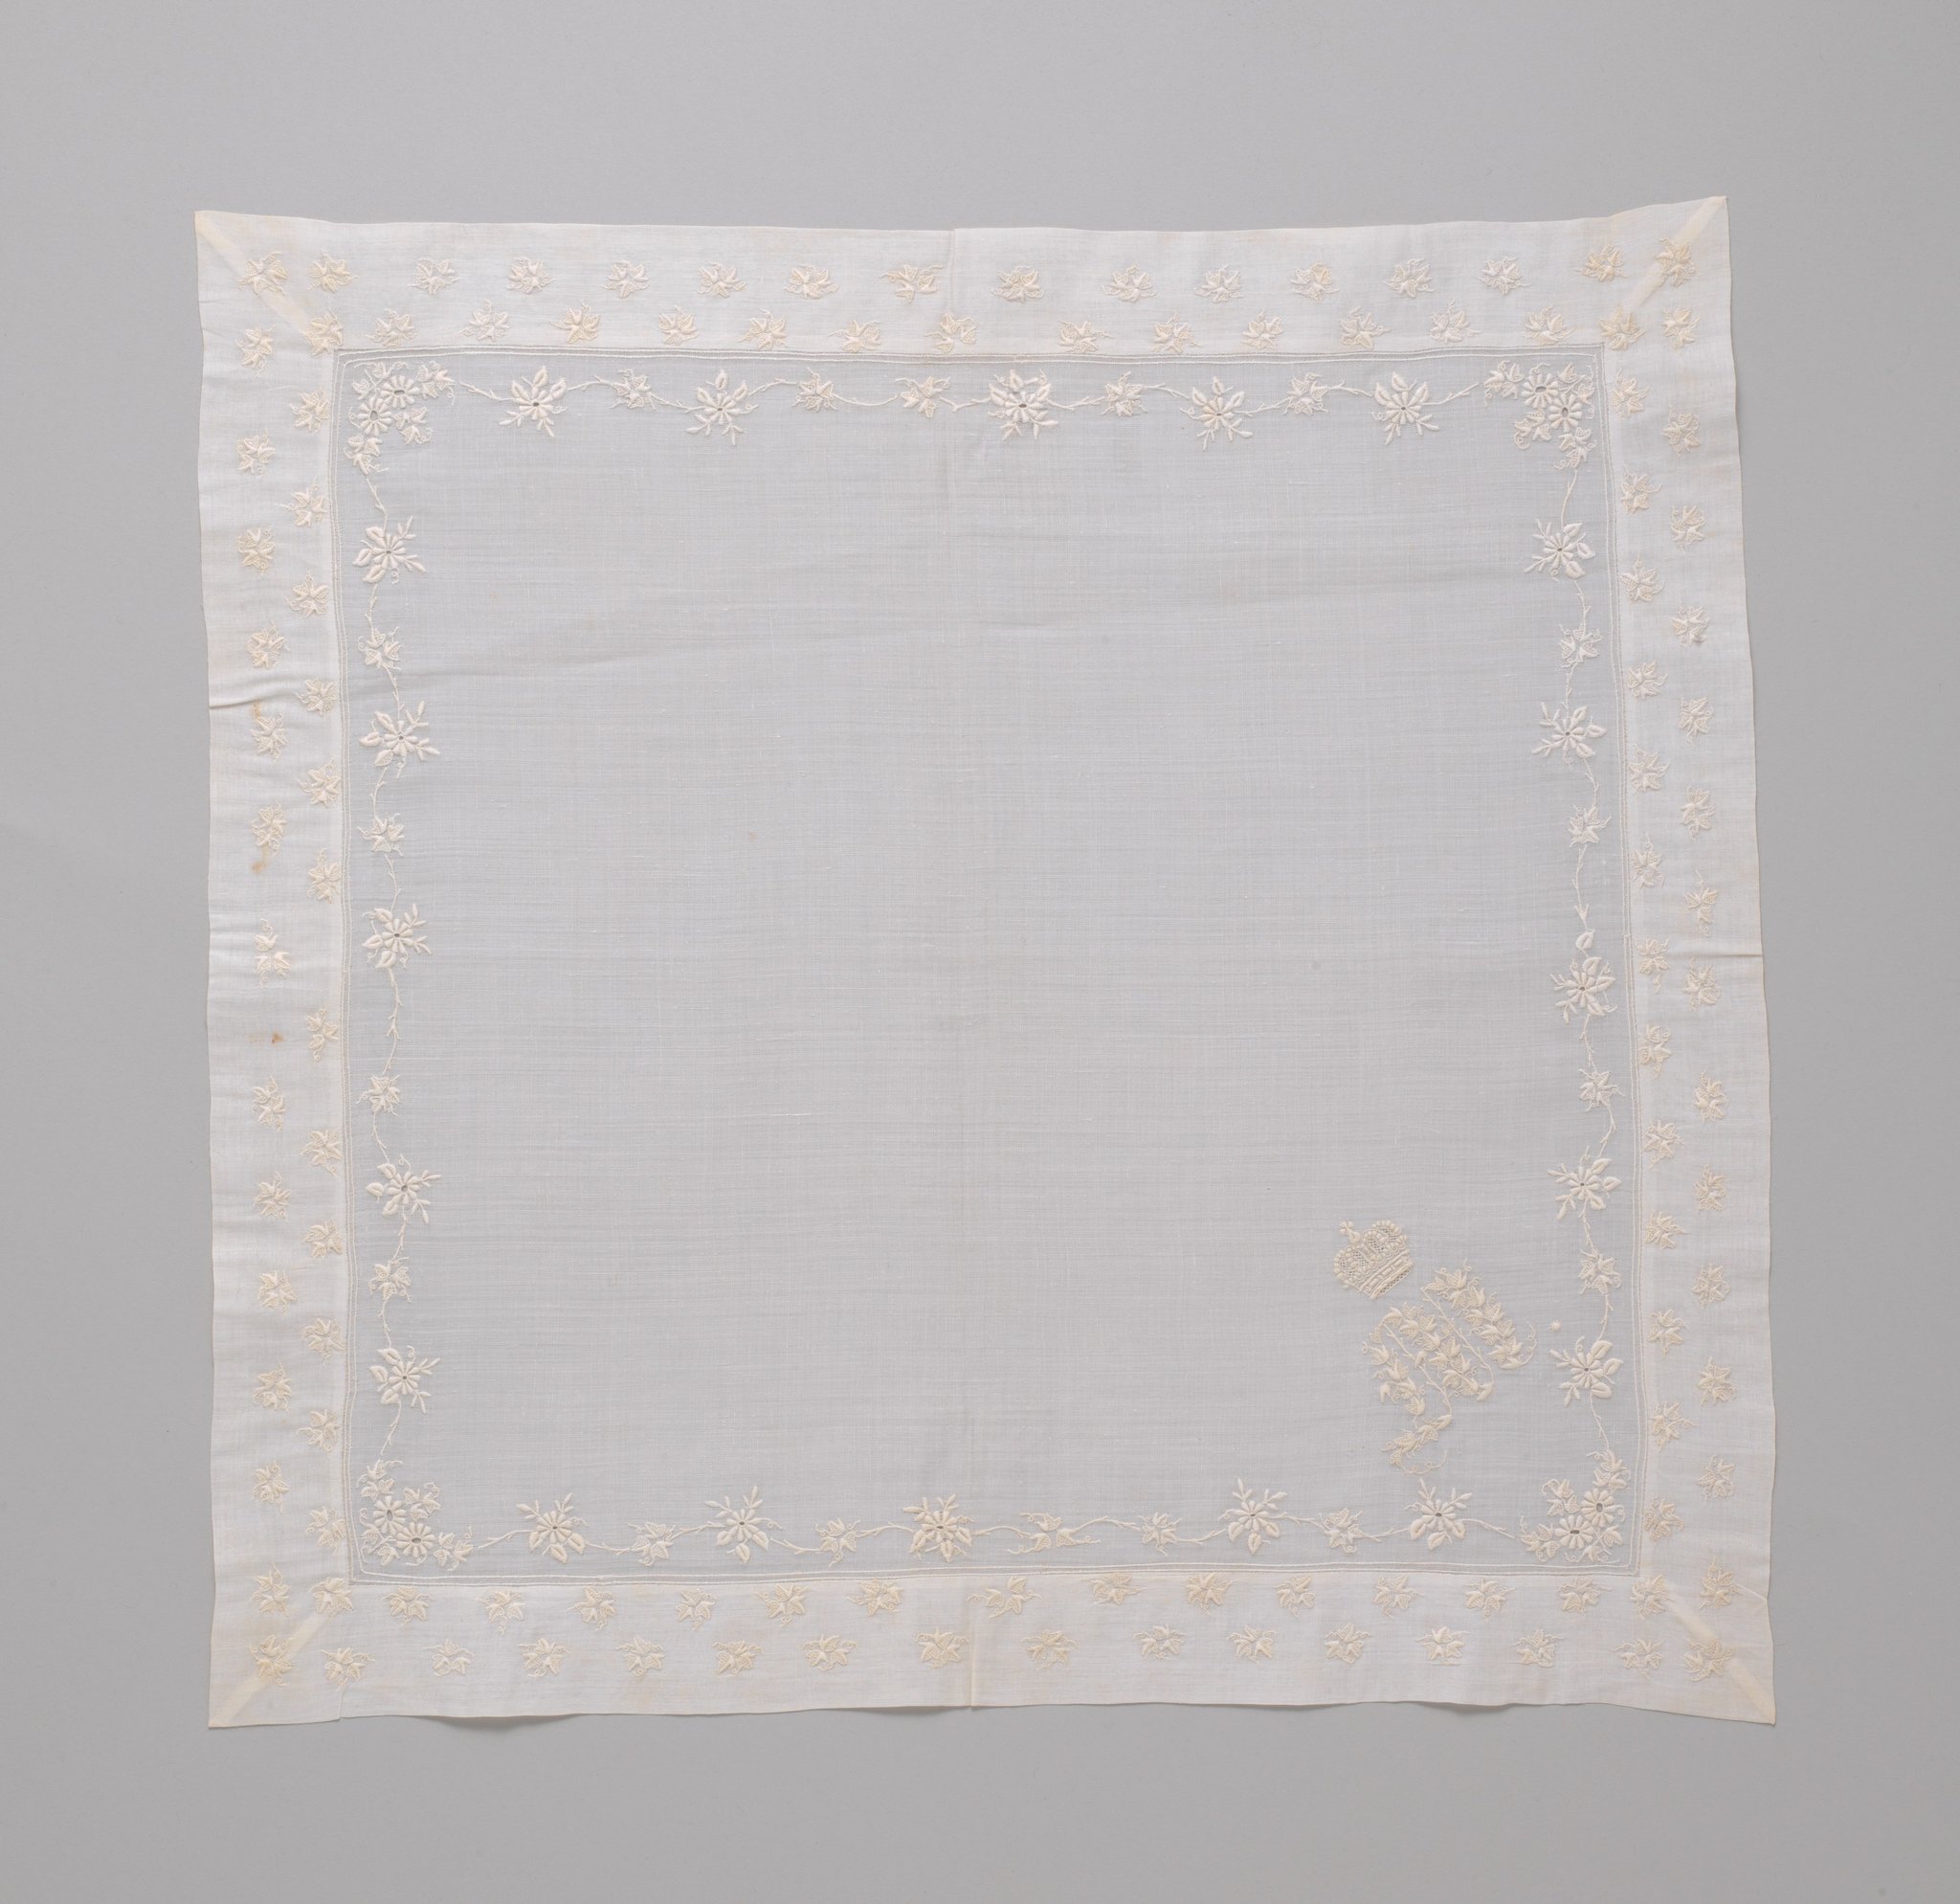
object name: handkerchief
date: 1840-1880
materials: linen, silk